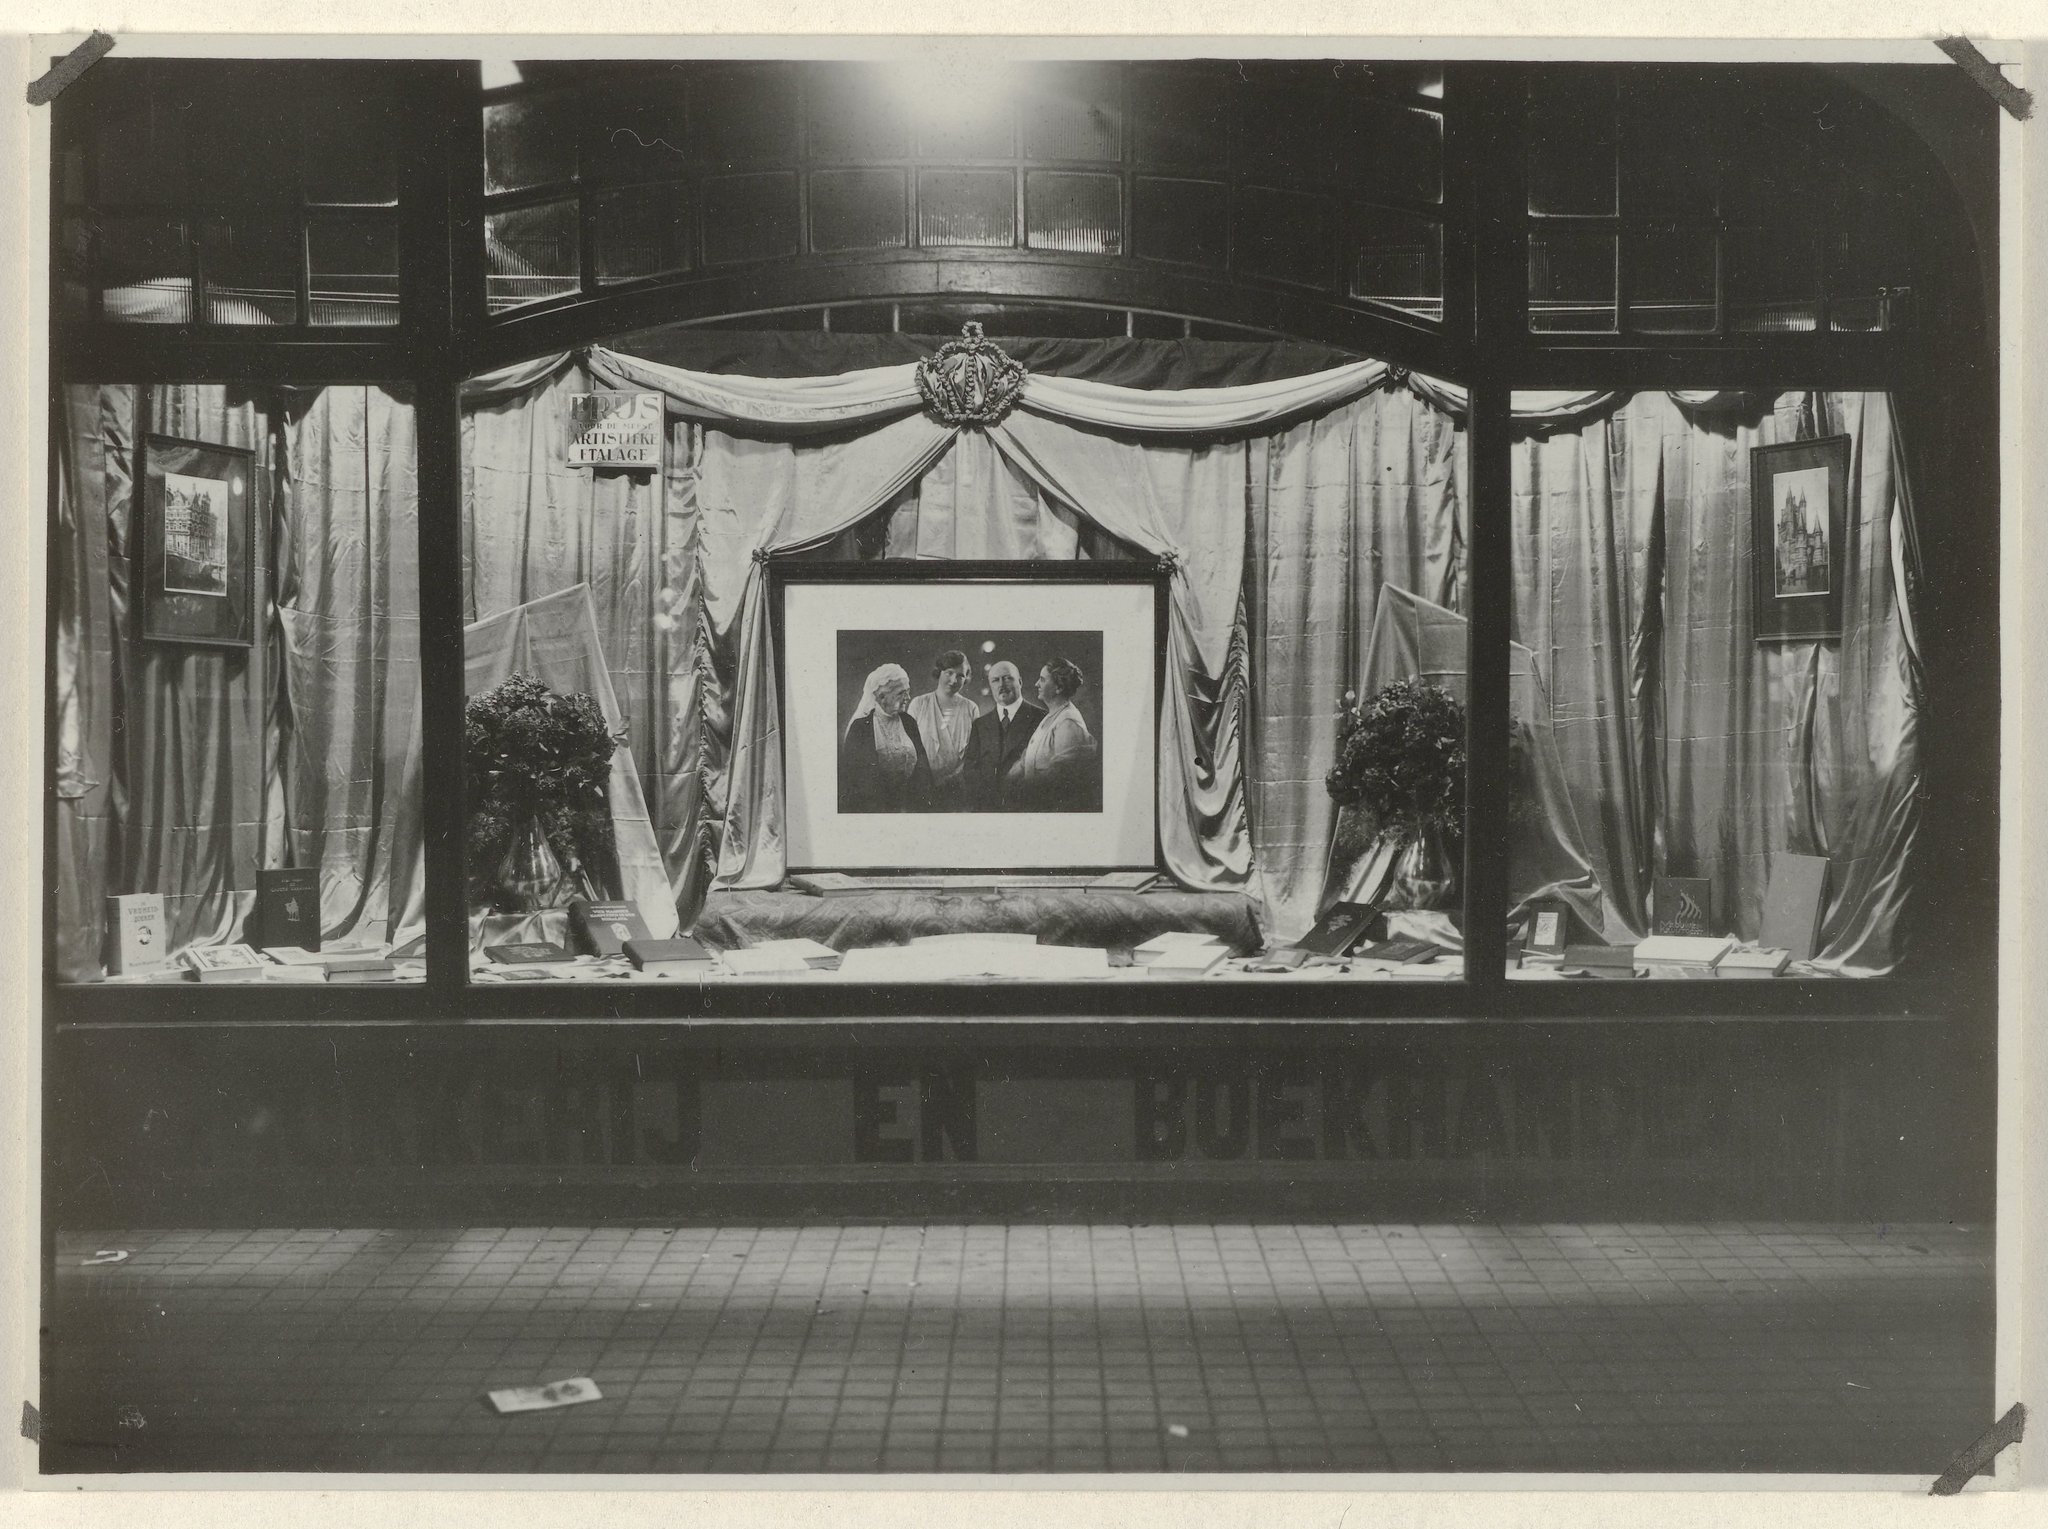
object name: photograph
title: Etalage van de winkel van de Deli Courant te Medan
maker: walter t. uhlenhuth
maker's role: fotograaf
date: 1908-1930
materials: photographic support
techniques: gelatin silver print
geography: medan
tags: dutch east indies, the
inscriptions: company name: ‘Foto Atelier en Handel W.T. Uhlenhuth Medan’, inscription: ‘Boekhandel Medan / Eerste prijs Artistike Etalage / Aug 1930 / Uitvoering J. de Ronde / Br. M. 13/9/30’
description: Versierde etalage van de winkel van de drukkerij en boekhandel van de Deli Courant te Medan. Prijswinnende etalage ingericht ter gelegenheid van de vijftigste verjaardag van koningin Wilhelmina op 31 augustus 1930. Onderdeel van een groep 49 losse zwart-wit foto's van verschillend formaat over de uitgeverij en drukkerij van de krant Deli Courant in Medan in de periode 1885-1947.